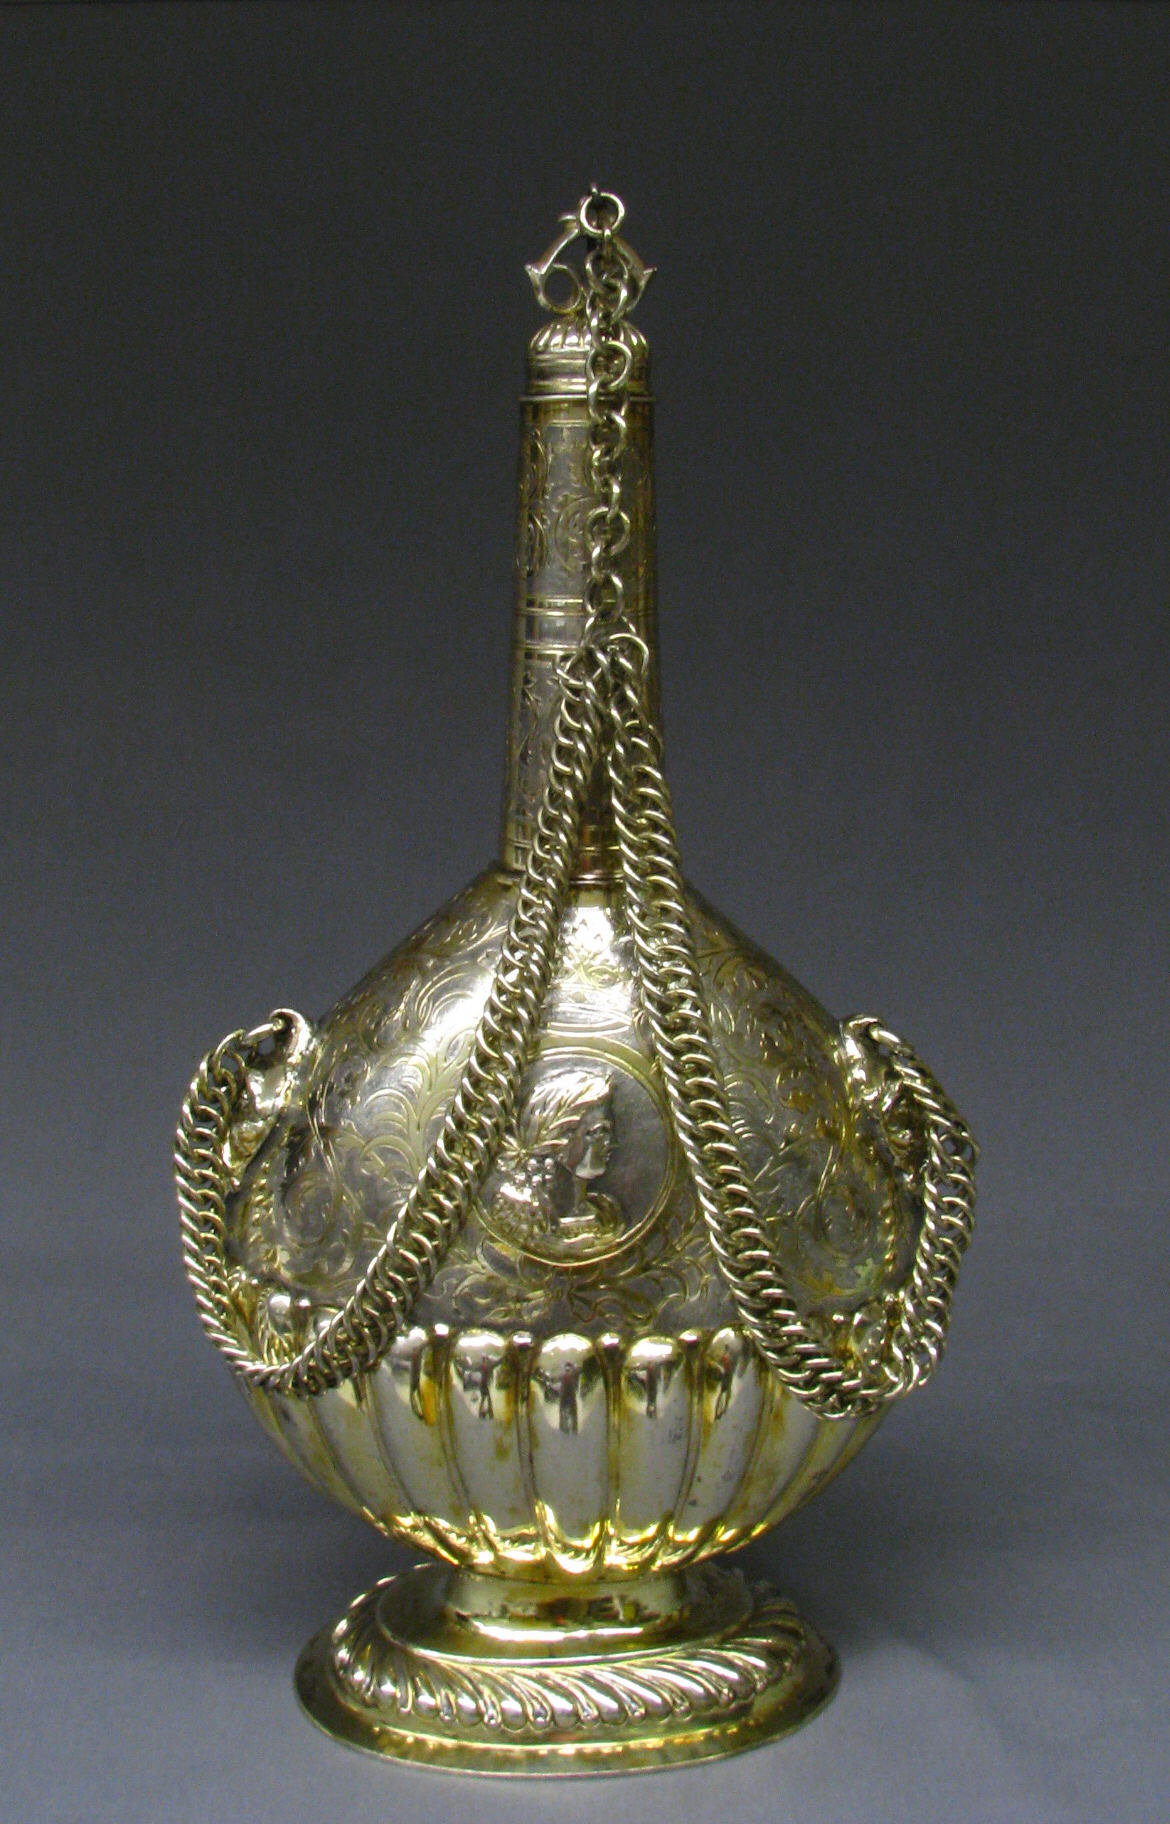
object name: pilgrim flask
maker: i.p.s.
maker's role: maker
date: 1680-1700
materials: silver, silver gilt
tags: profiles,women